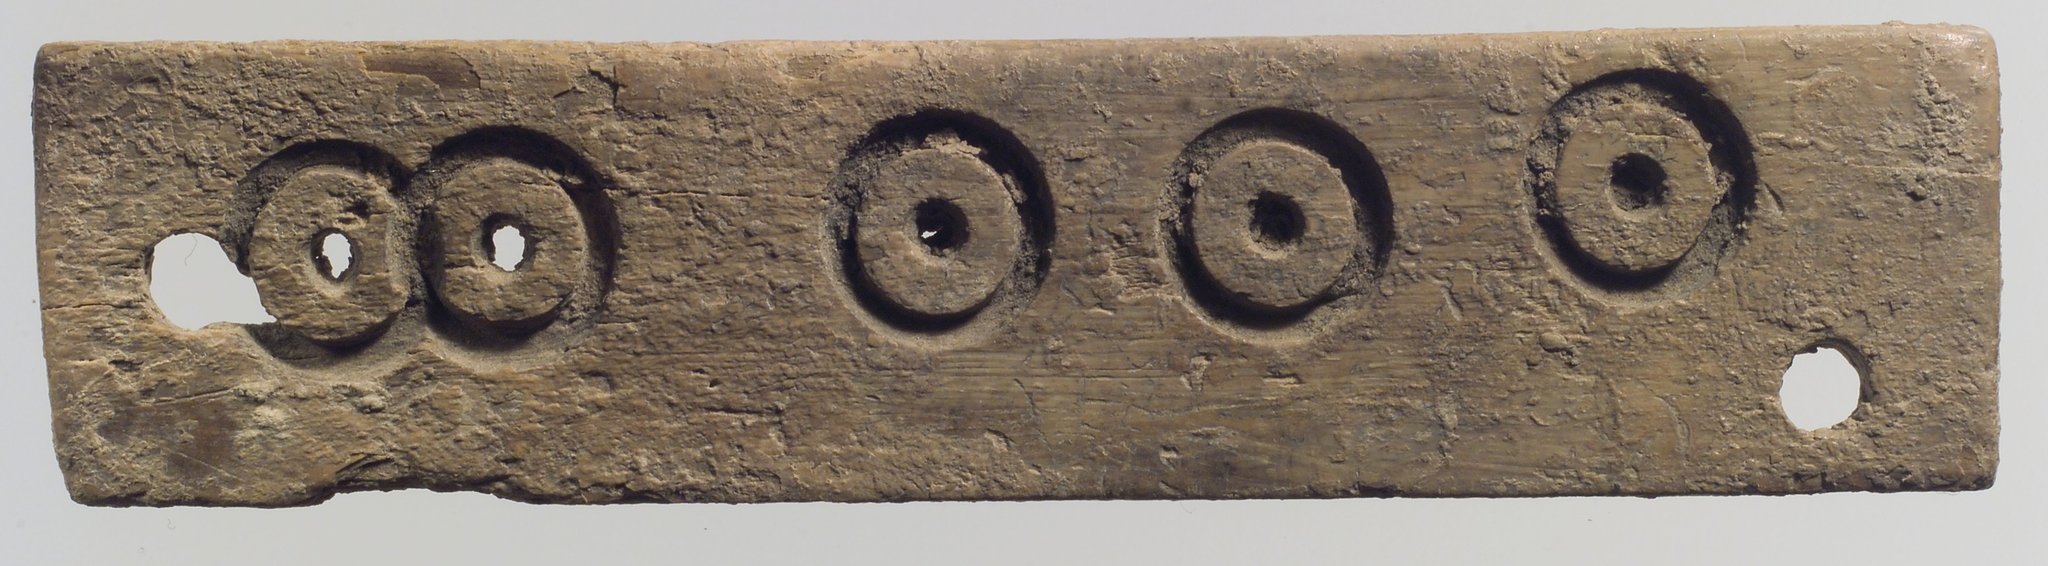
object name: inlay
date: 1780-1580 BCE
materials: bone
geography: levant